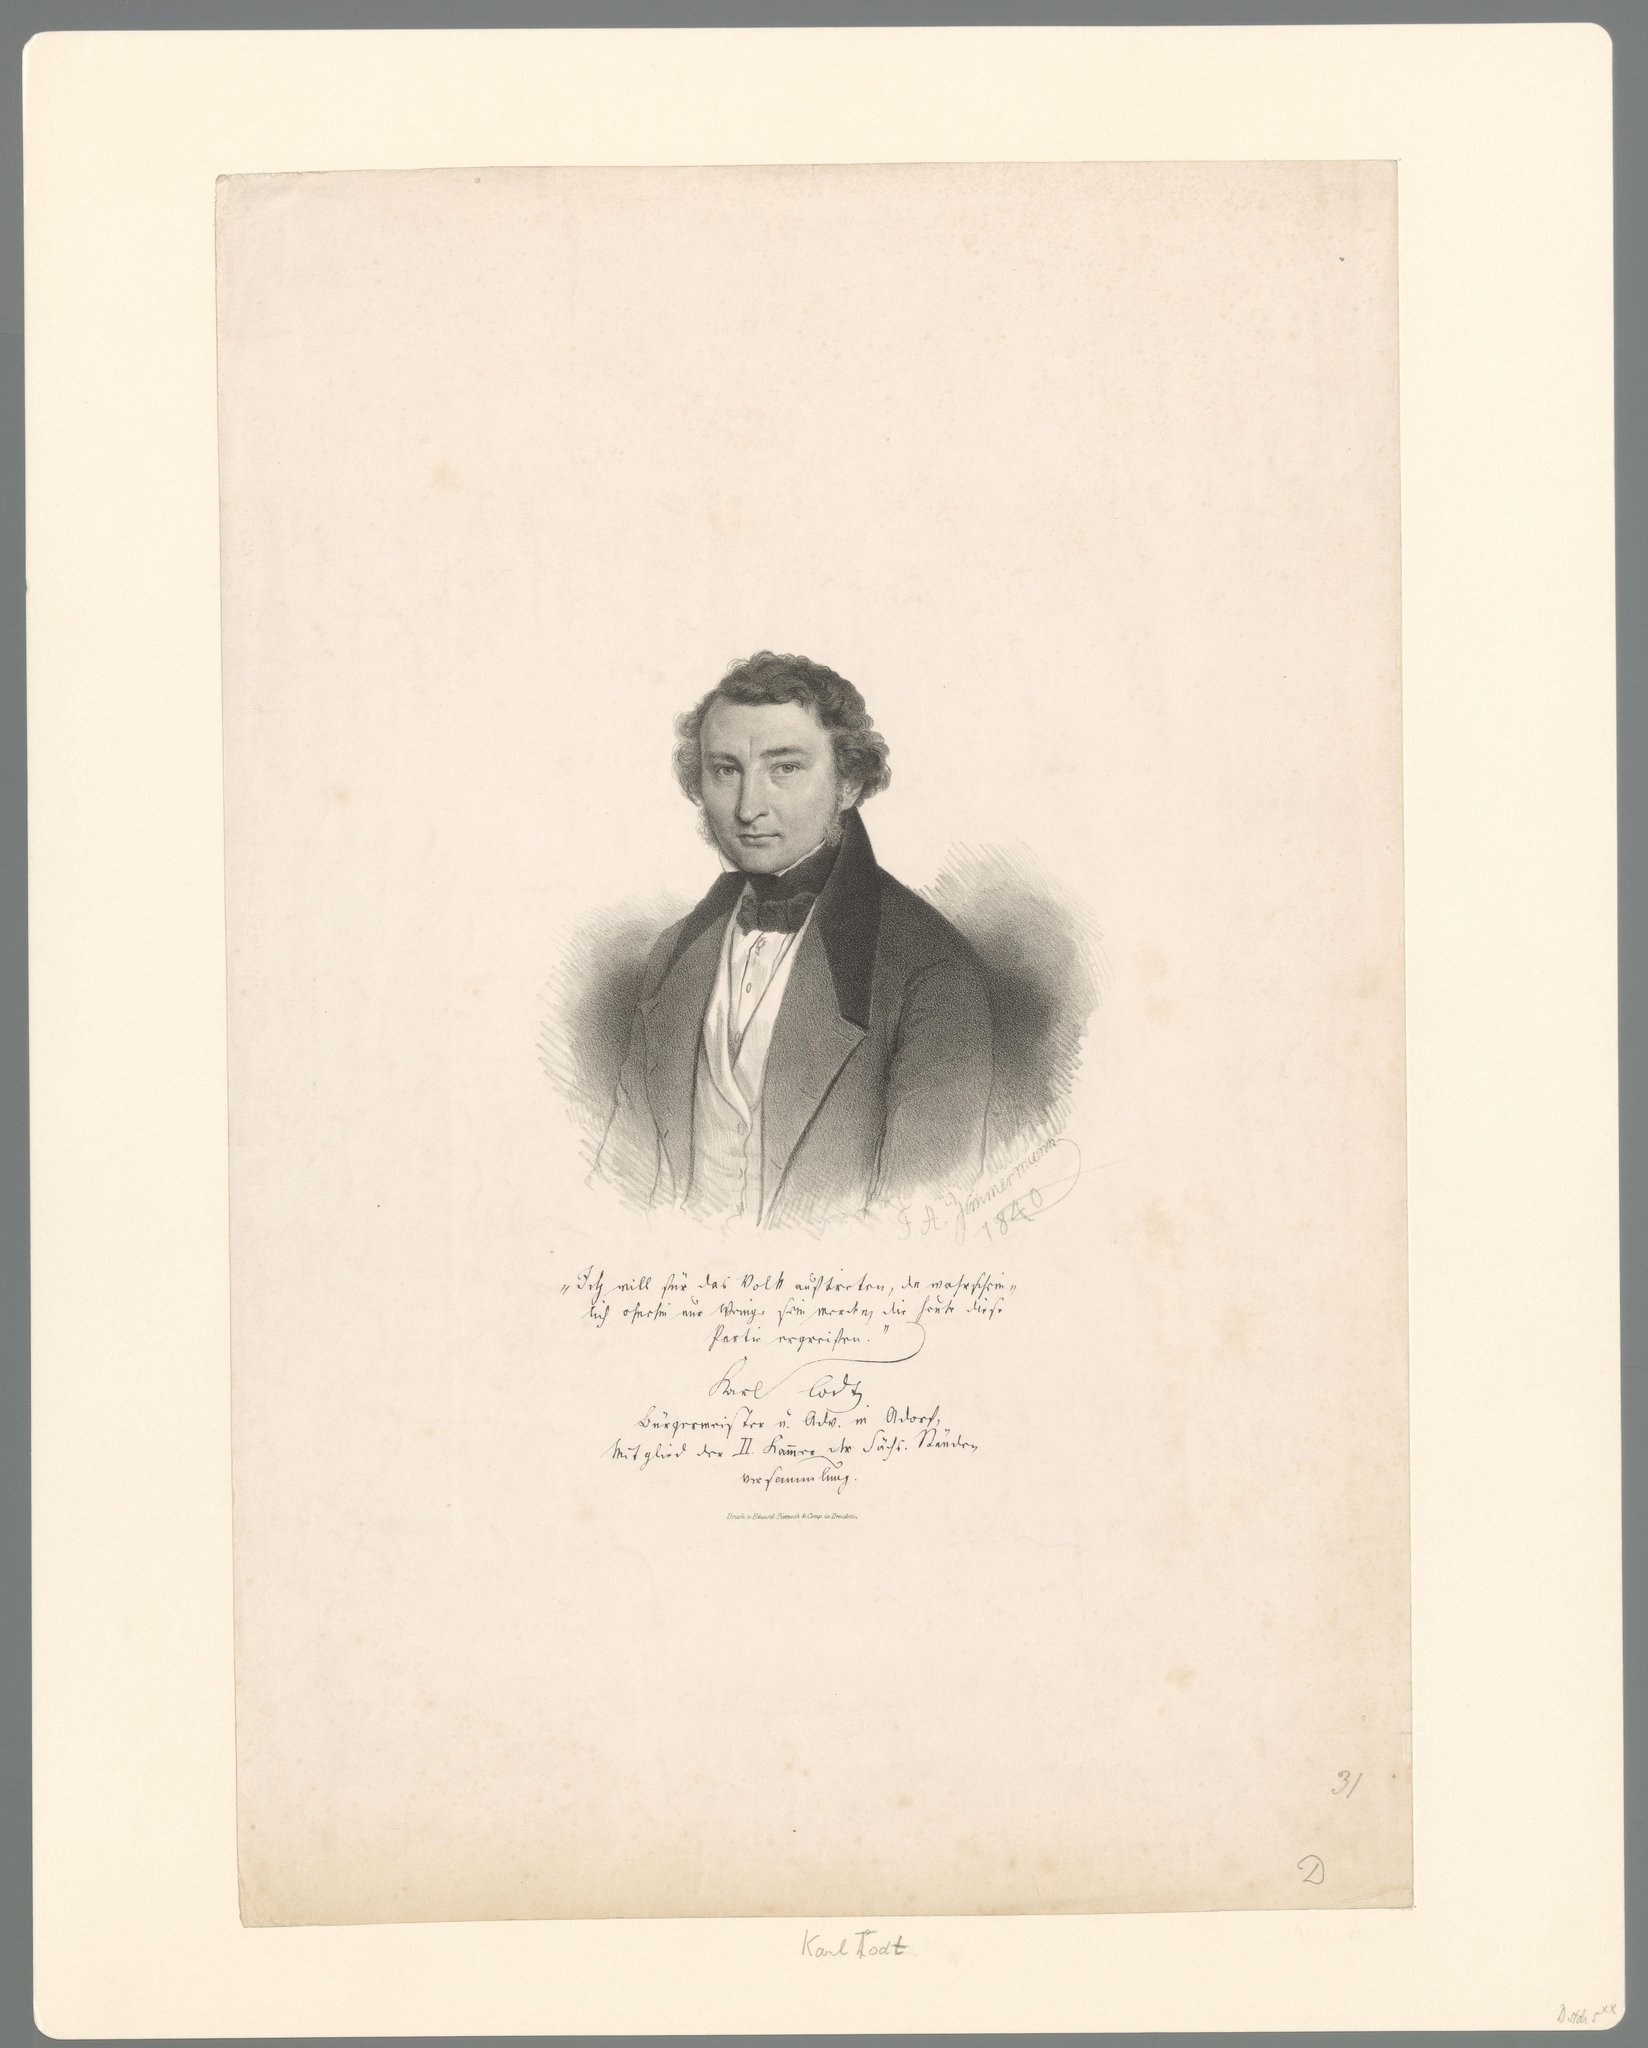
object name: print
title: Portret van Karl Gotthelf Todt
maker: friedrich august zimmermann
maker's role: print maker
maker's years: 1805-1876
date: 1840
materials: paper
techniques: lithograph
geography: dresden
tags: politician, adult man, historical persons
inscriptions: collector's mark: Lugt 2228